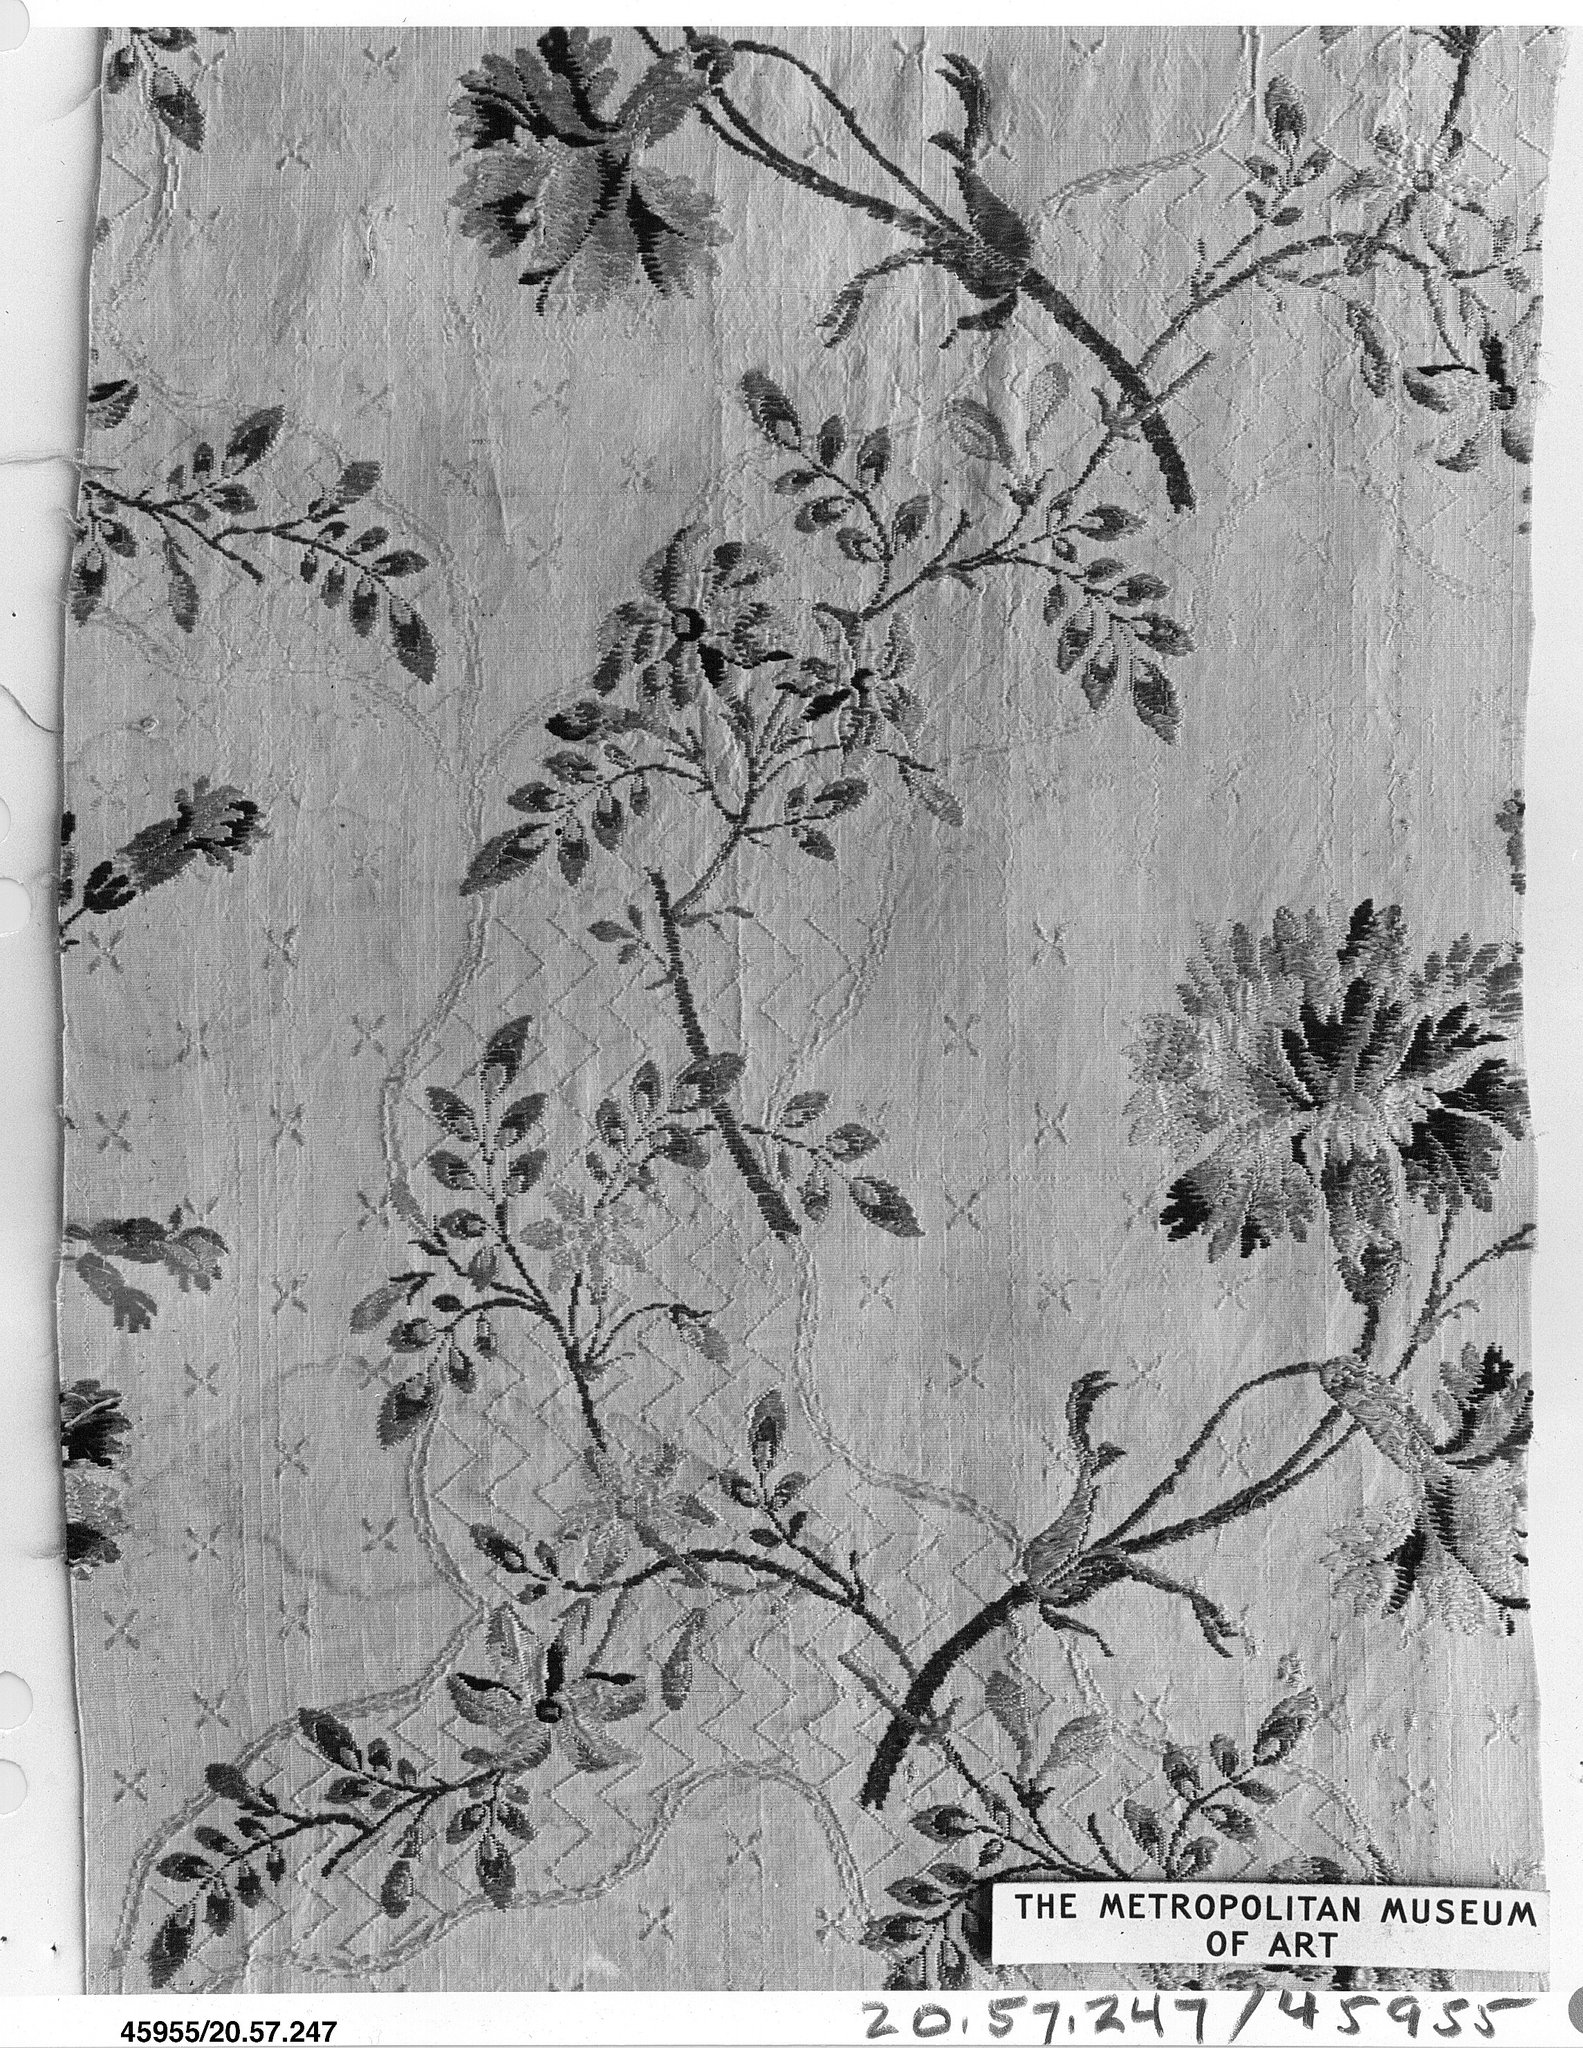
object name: piece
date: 1750-1760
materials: silk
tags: flowers,leaves